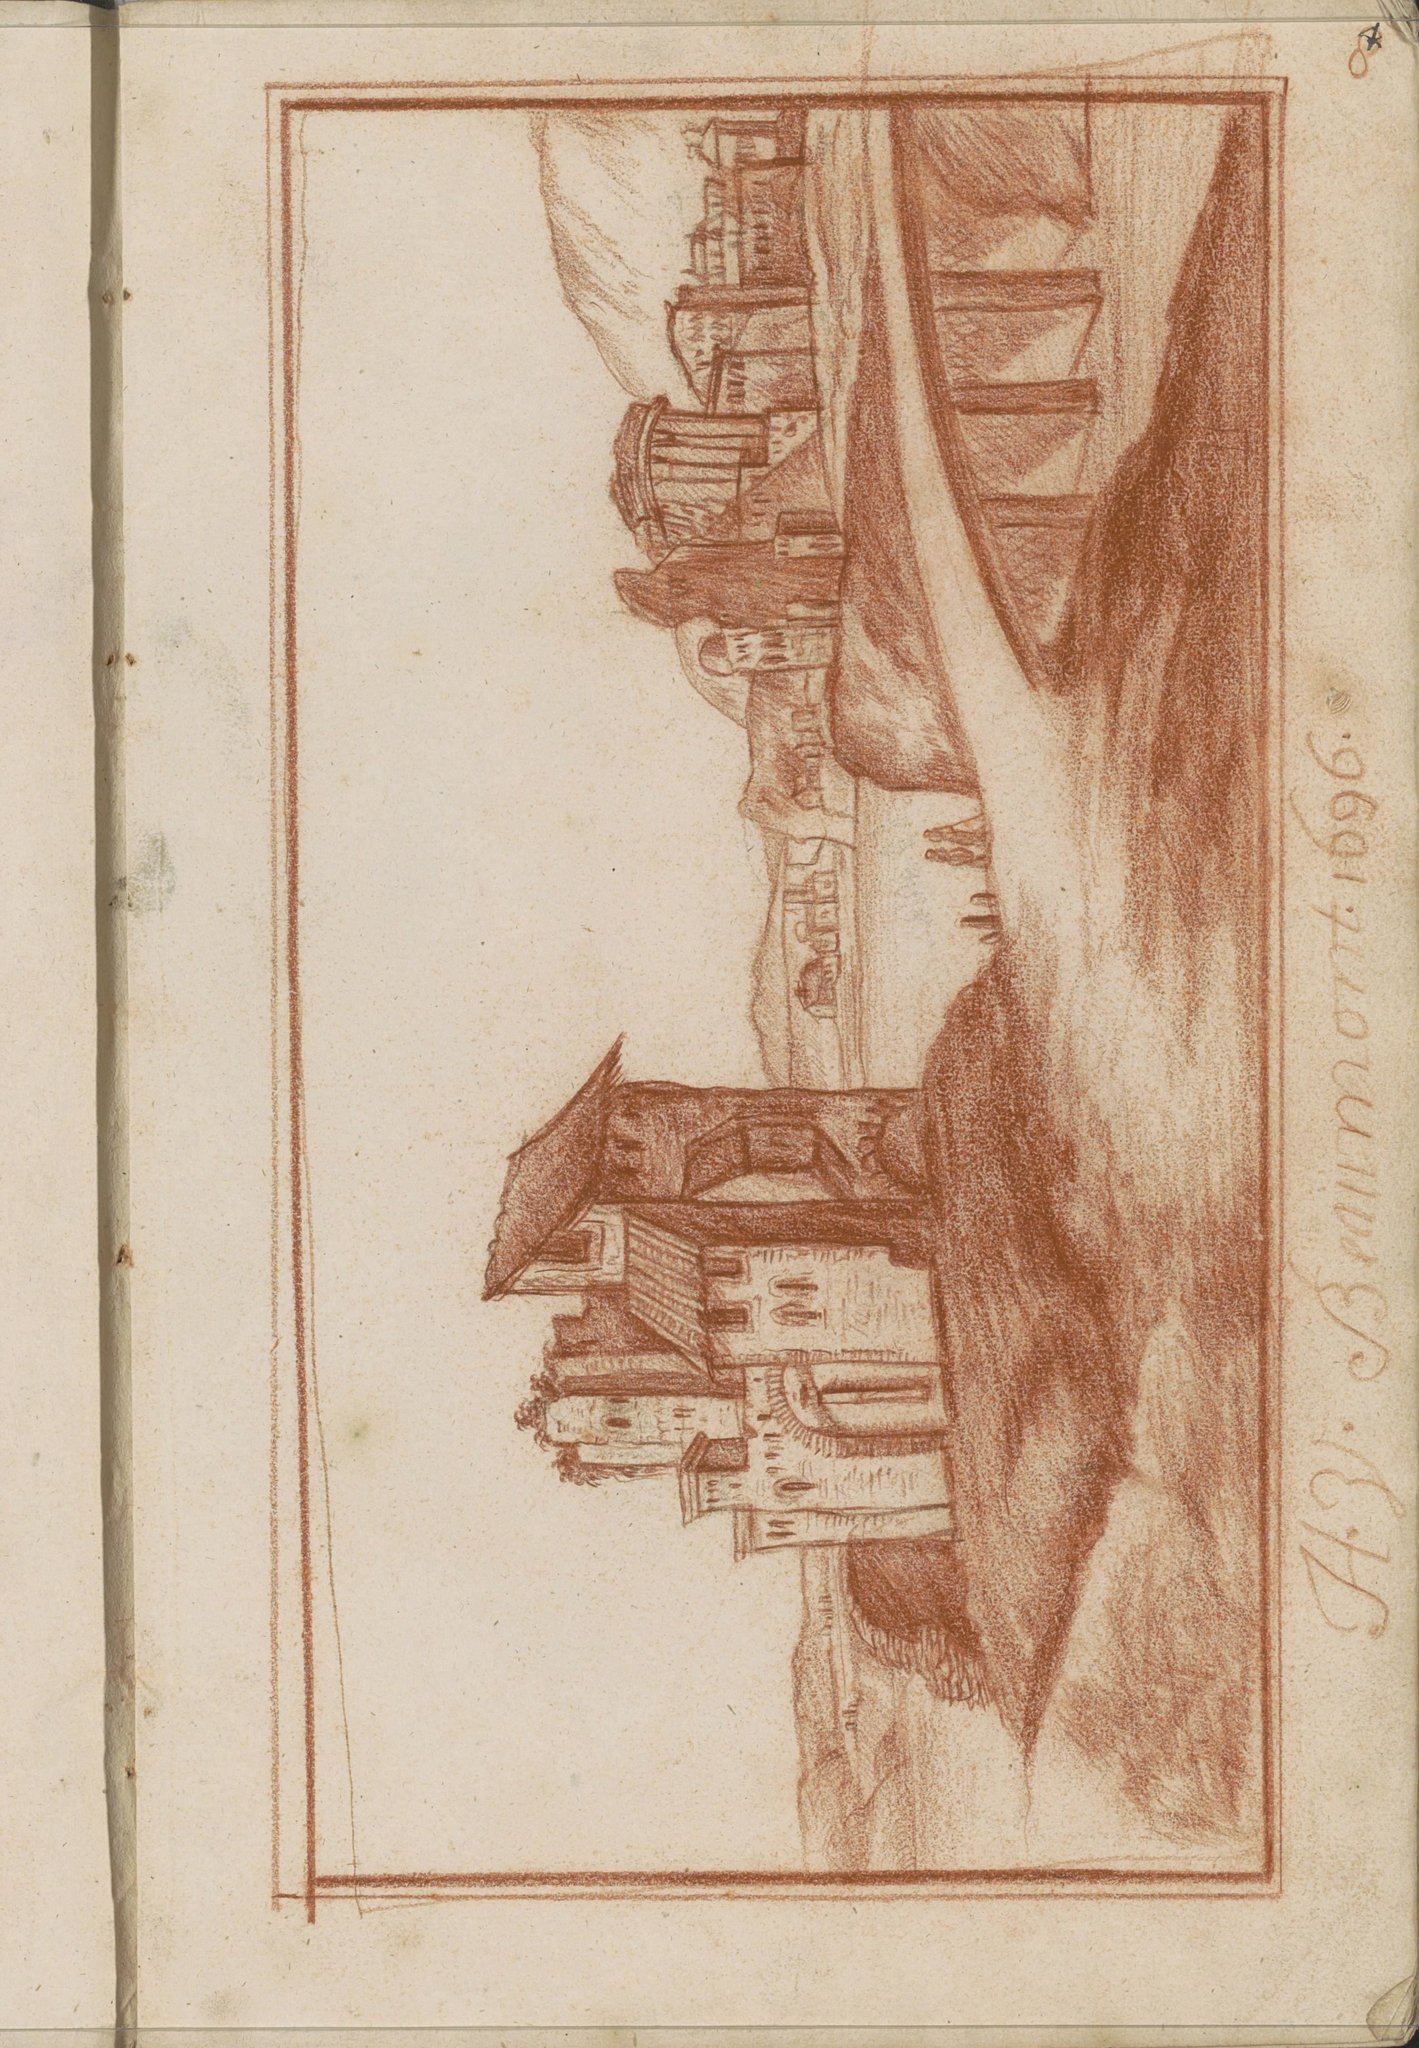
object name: sketchbook leaf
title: Heuvellandschap met een brug over een rivier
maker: hendrick van beaumont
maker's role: draughtsman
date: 1696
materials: chalk, paper, pencil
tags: city-view, and landscape with man-made constructions, bridge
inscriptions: number: ‘8’, signature and date: ‘H.V. Beaumont.1696.’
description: Bij de brug staan twee figuren. Blad 6 recto uit een schetsboek met 30 bladen.